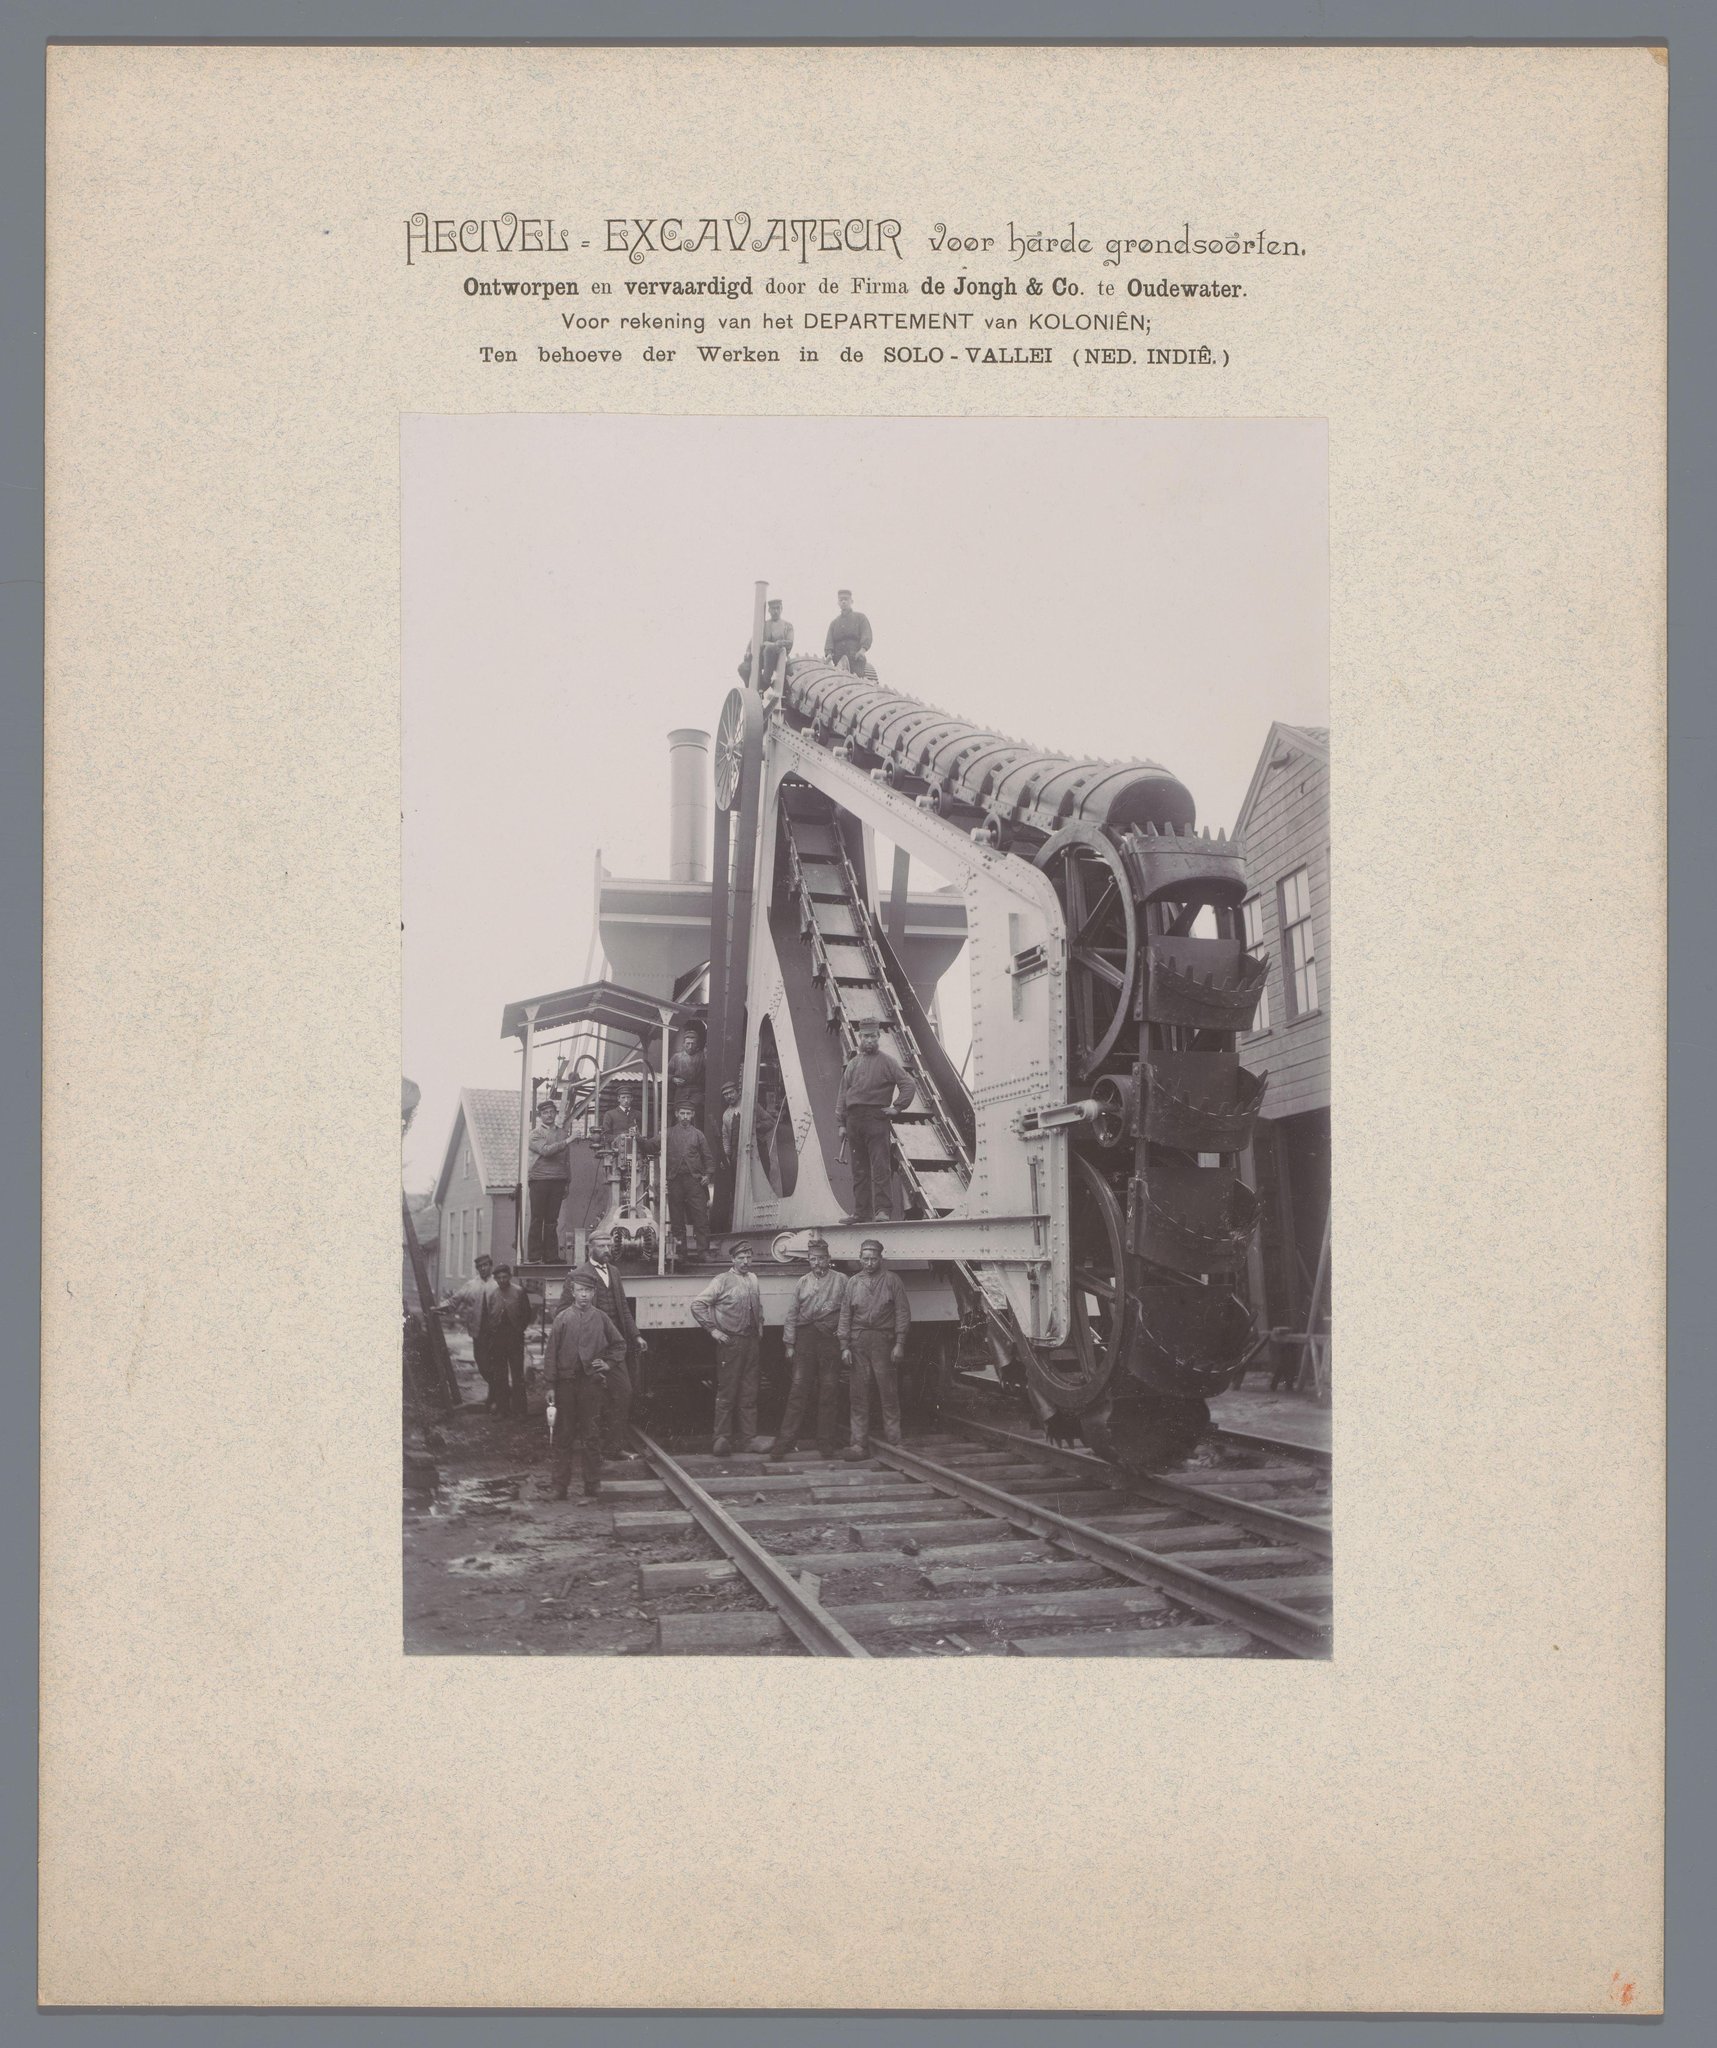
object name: photograph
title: Heuvel-Excavateur voor harde grondsoorten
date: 1875-1900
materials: cardboard, paper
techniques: photography, printing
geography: oudewater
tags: indië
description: Foto op grijs papier, van machine op rails. Opschrift; b.: 'Ontworpen en vervaardigd door de Firma de Jongh & Co te Oudewater / Voor rekening van het DEPARTEMENT van KOLONIEN. / Ten behoeve der Werken in de SOLO-VALLEI (NED. INDIE).